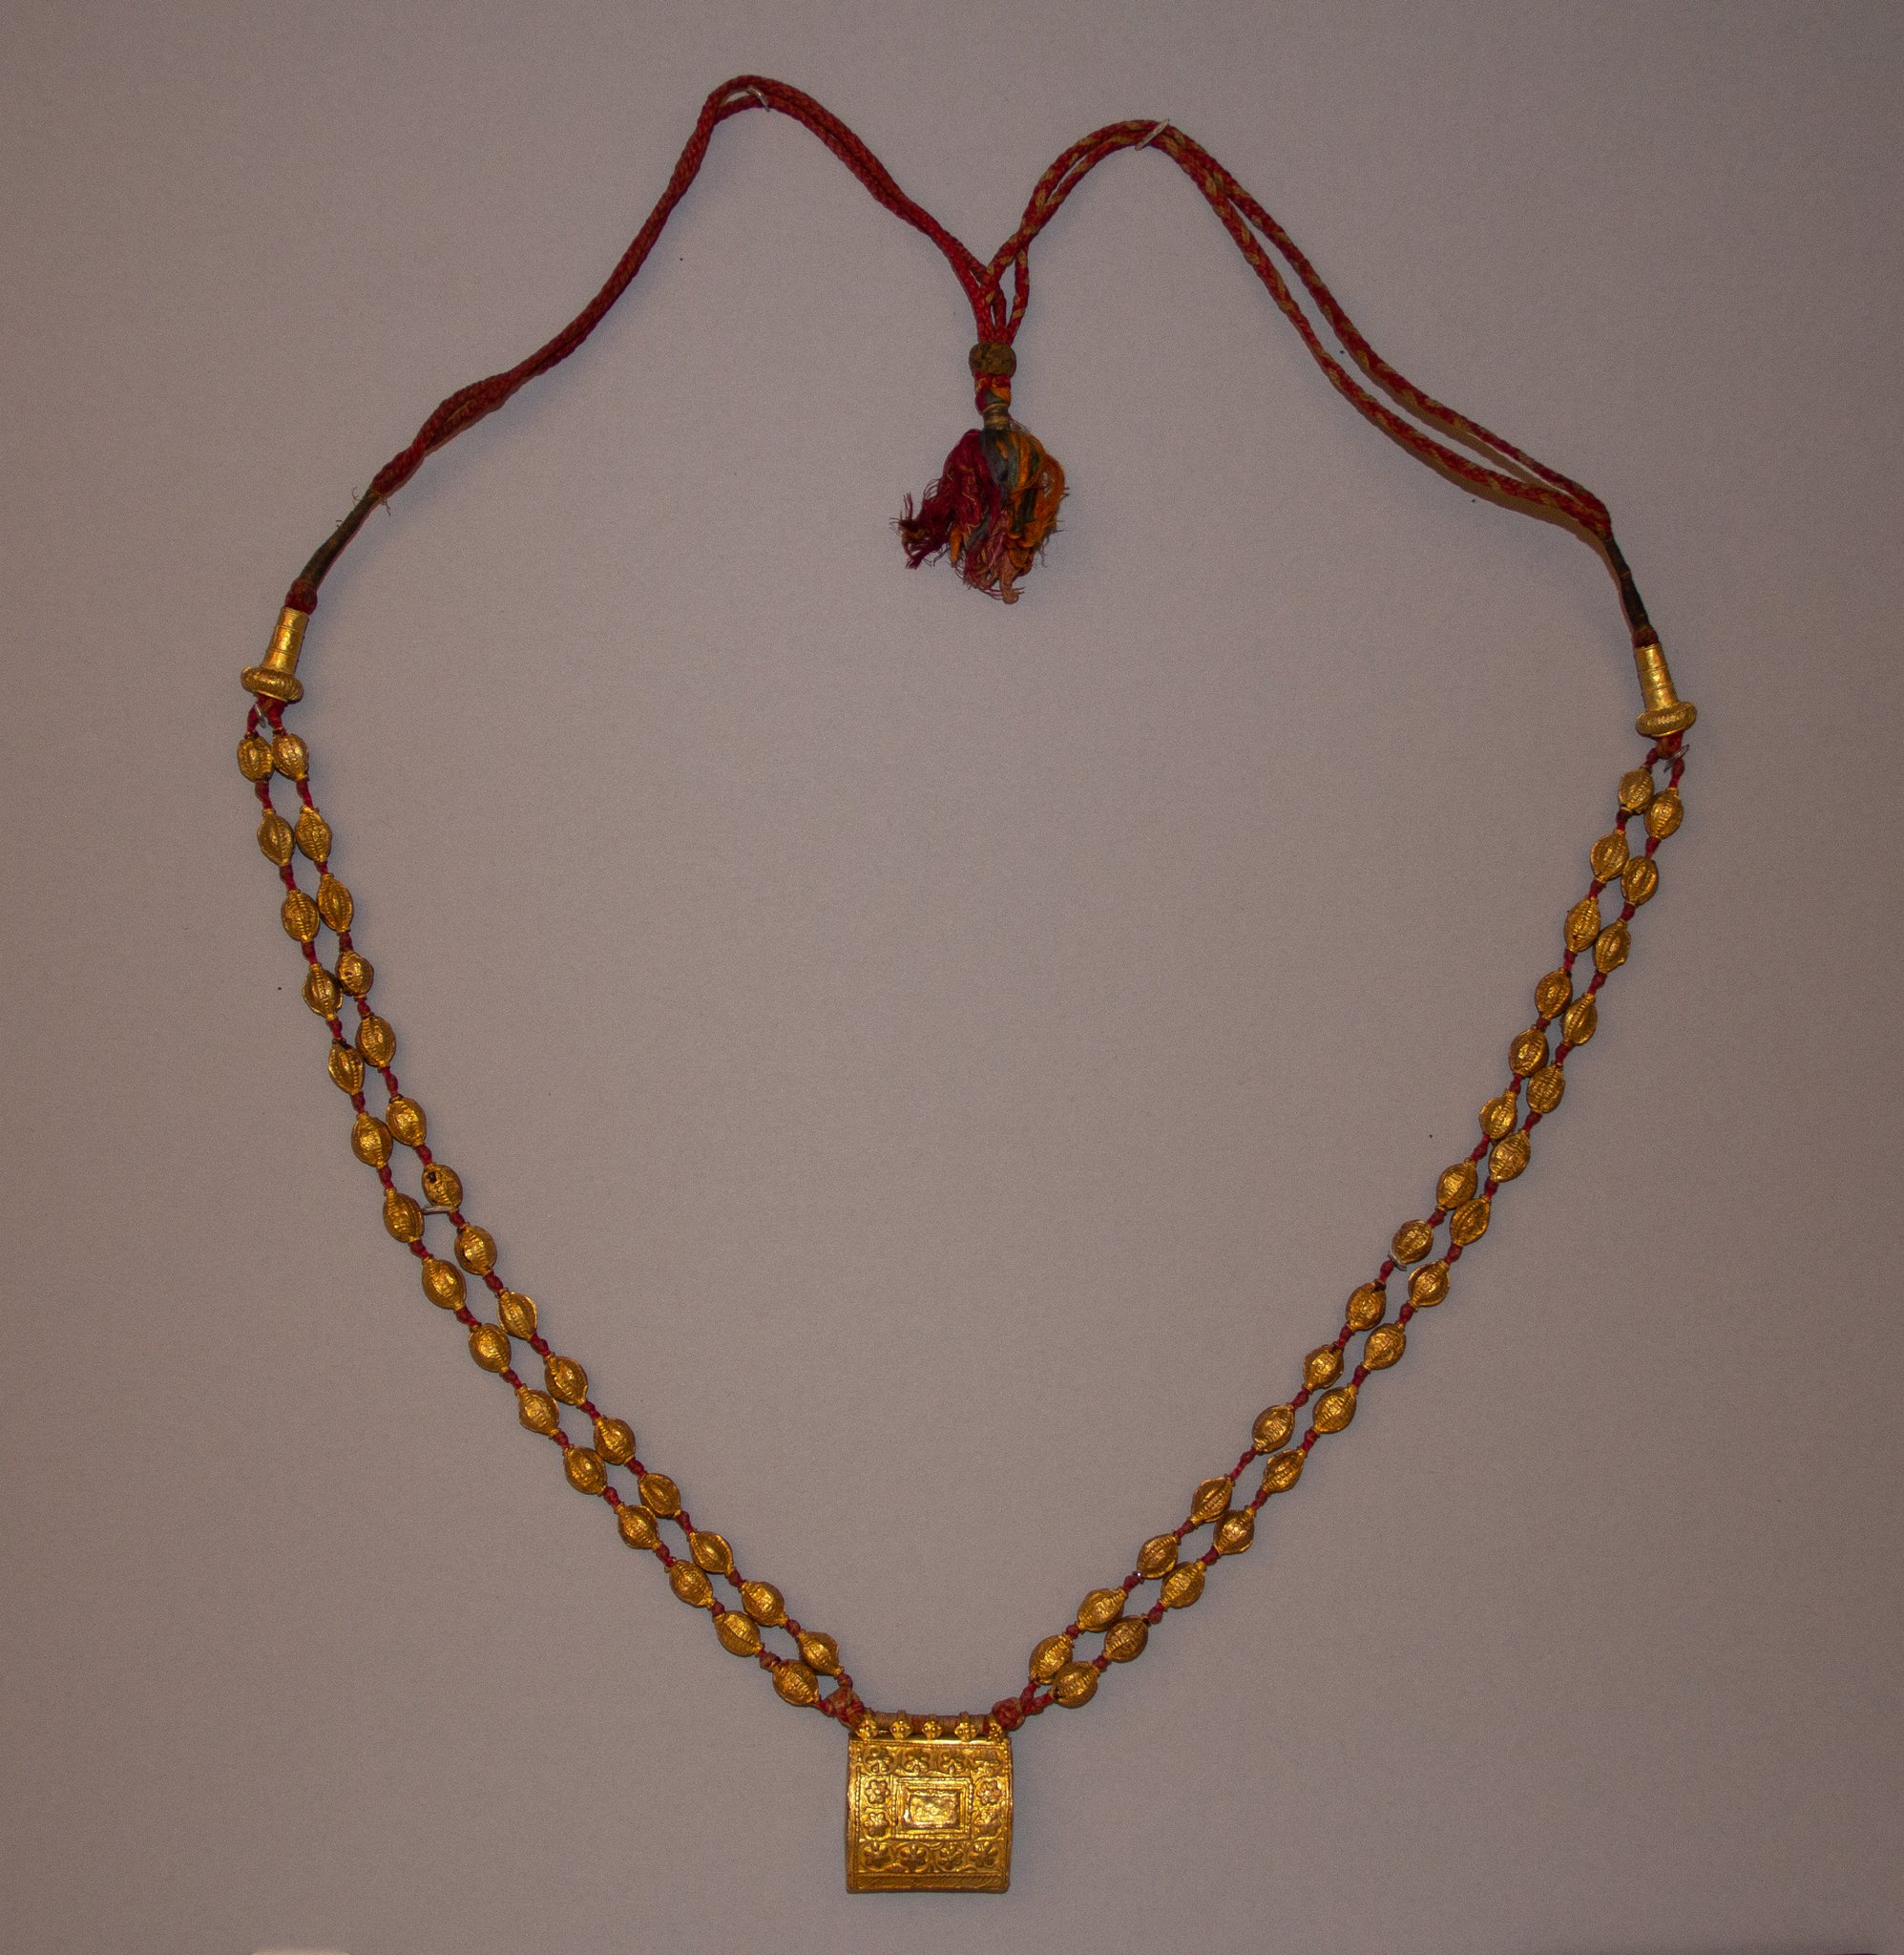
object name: necklace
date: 1701-1900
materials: gold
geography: india